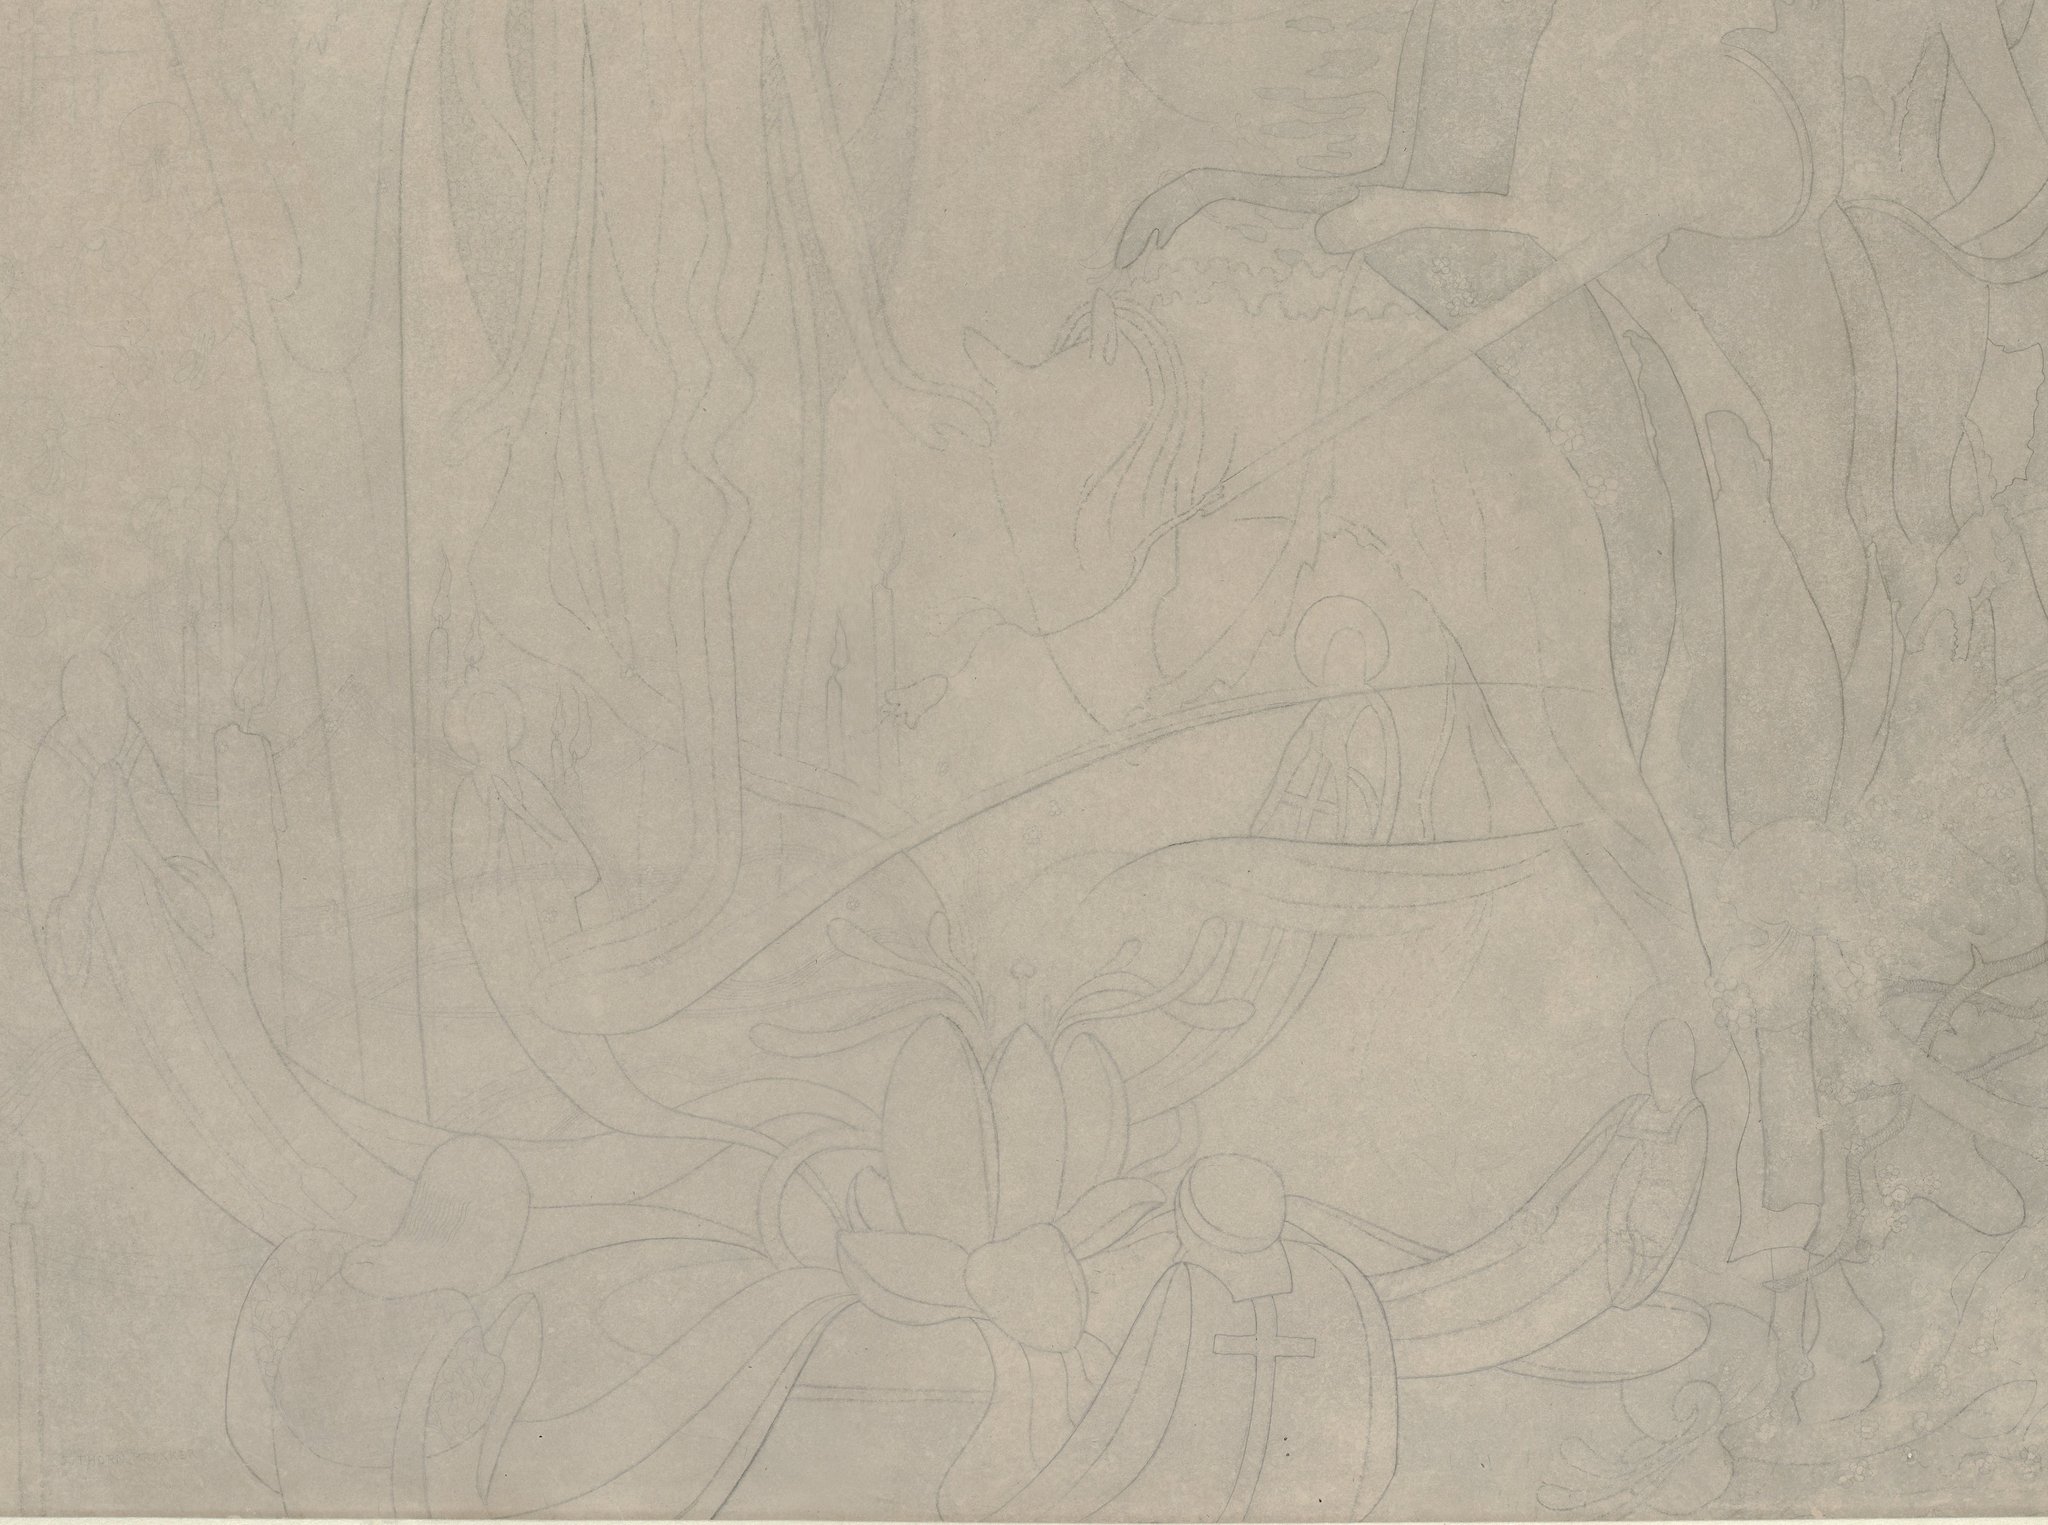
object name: drawing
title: Graalridders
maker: johan thorn prikker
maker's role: draughtsman, print maker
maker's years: 1868-1932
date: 1878-1932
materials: chalk, paper, pencil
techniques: spatter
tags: riding a horse, ass, or mule; rider, horseman, male characters from arthurian legend : use 82a(...)